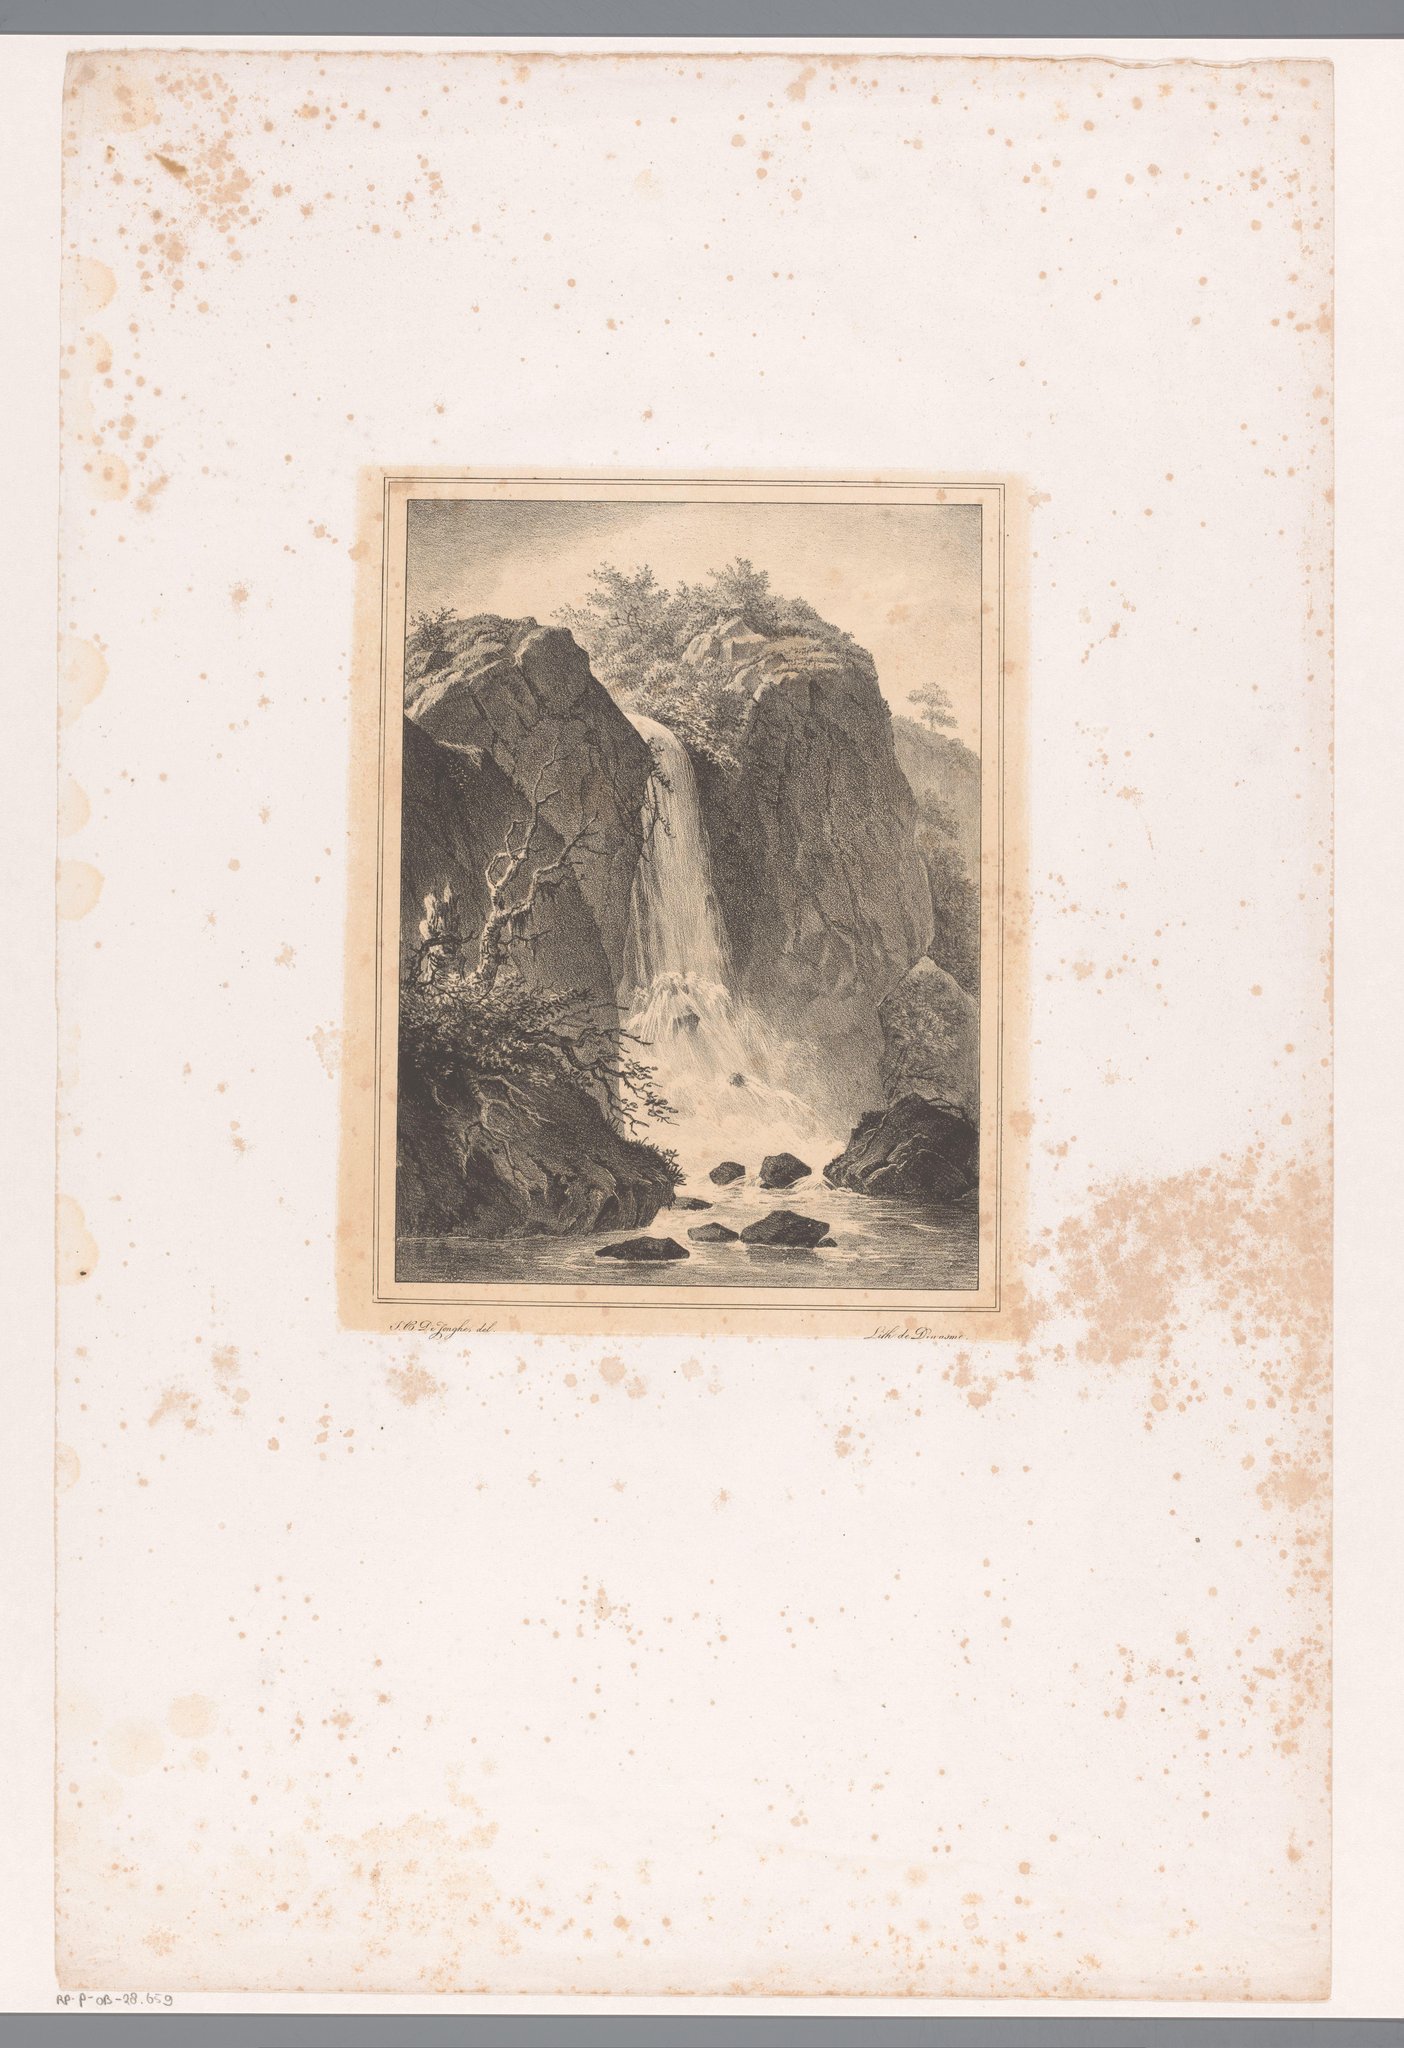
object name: print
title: Waterval tussen rotsen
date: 1800-1844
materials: paper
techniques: lithograph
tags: waterfall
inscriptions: collector's mark: Lugt 2228